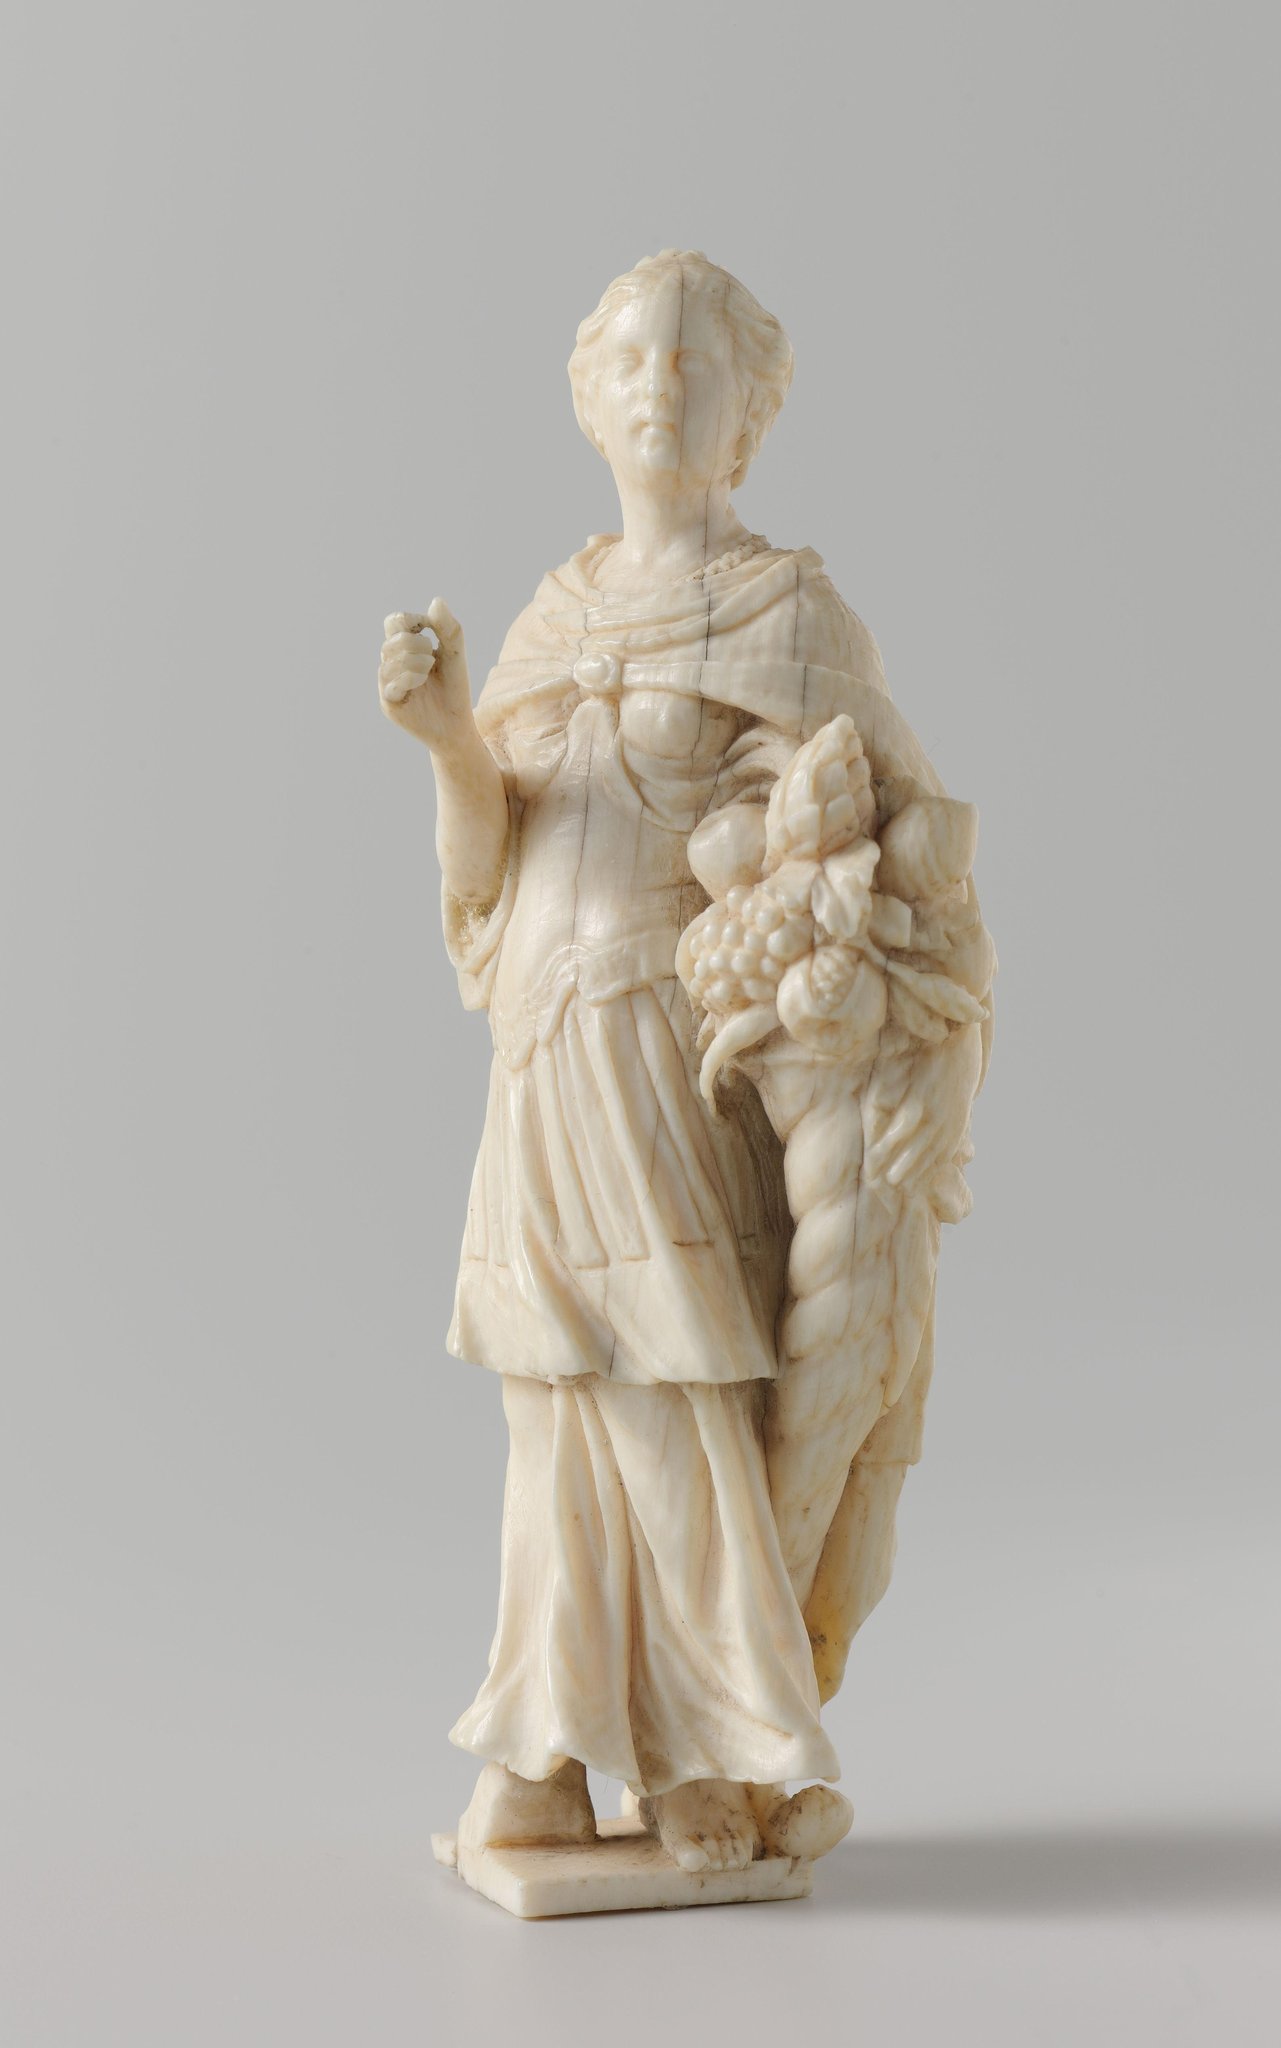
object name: sculpture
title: Europe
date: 1670-1700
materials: ivory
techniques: cutting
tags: europe represented allegorically; 'europa' (ripa)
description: Europe and Africa. Ivory, Netherlands, c. 1660.